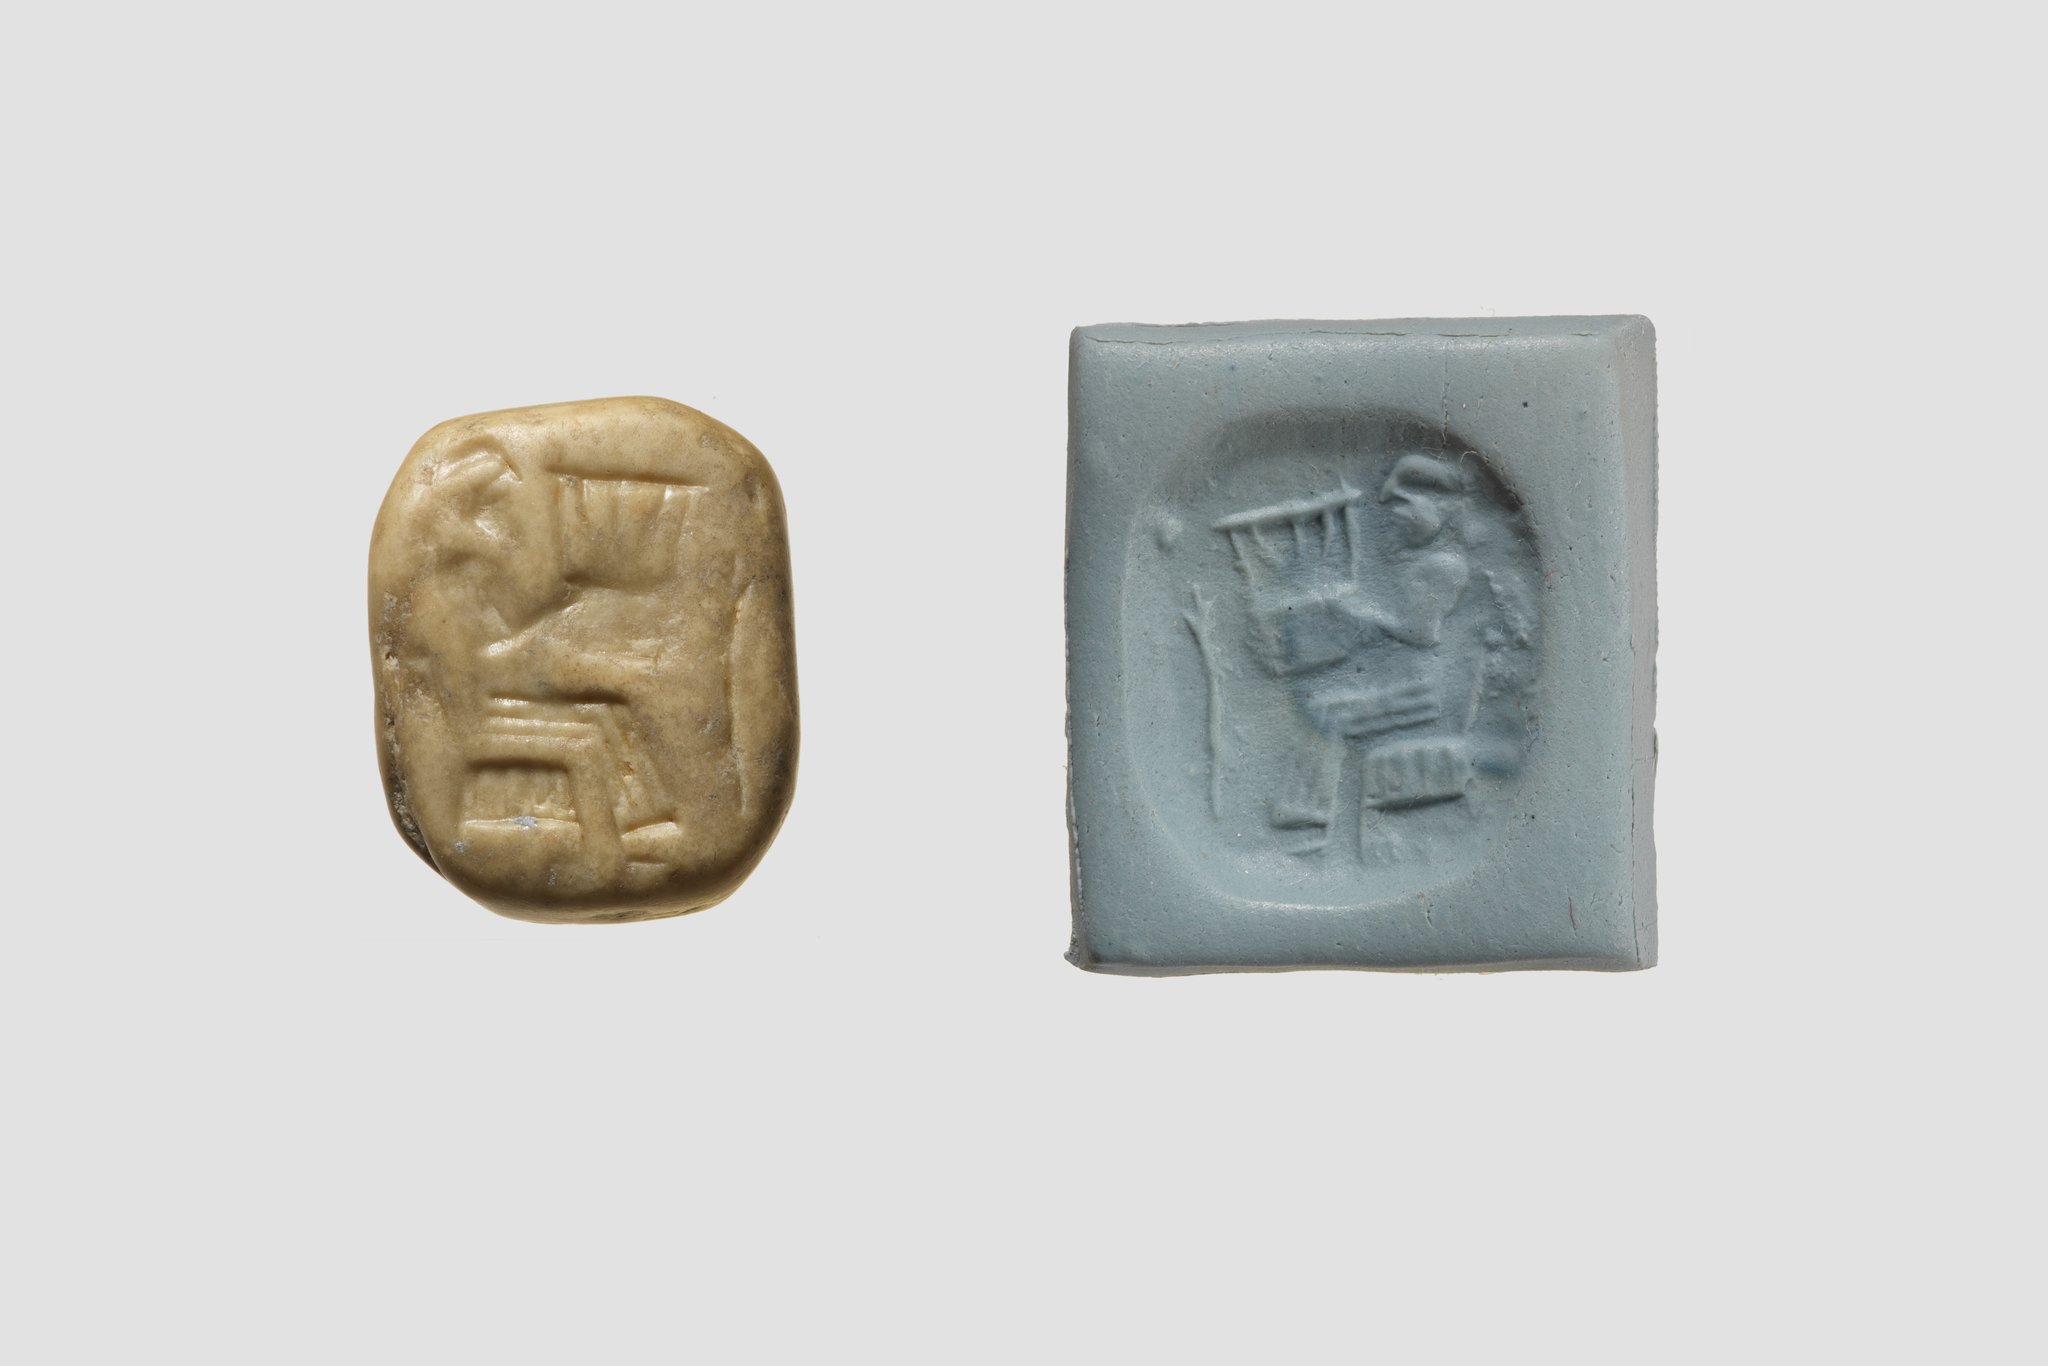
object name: stamp seal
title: Stamp seal (octagonal pyramid, worn) with musician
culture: syro-levantine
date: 750-701 BCE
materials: limestone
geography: mesopotamia or syria (?)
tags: men,lyres